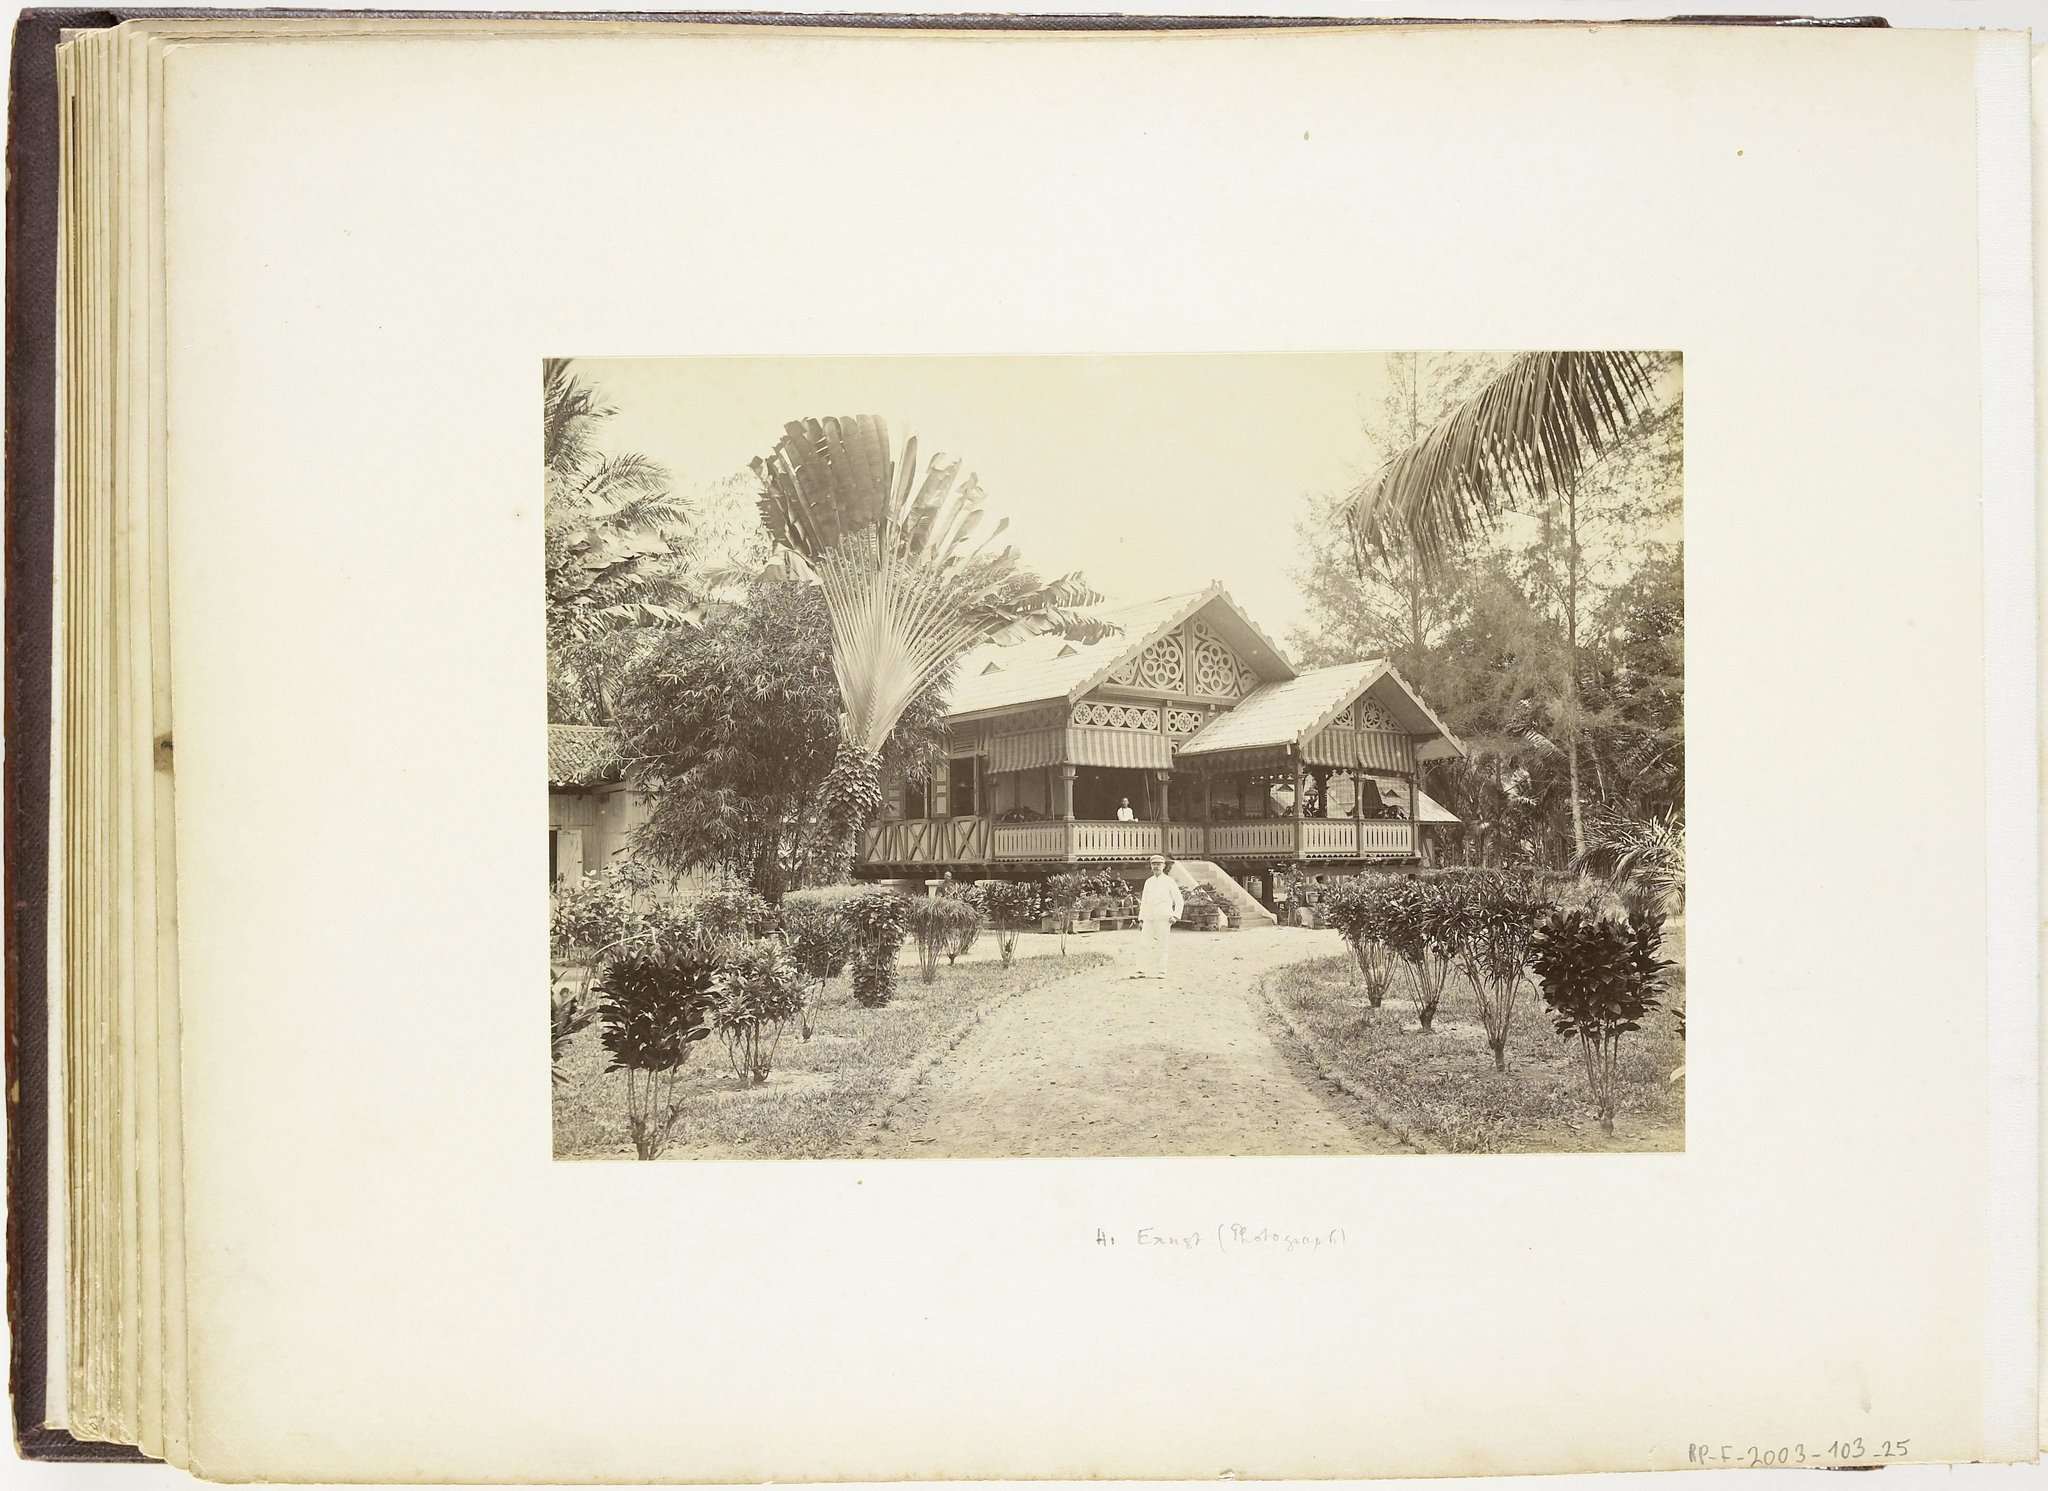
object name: photograph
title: Portret van de fotograaf H. Ernst voor zijn huis, Langkat Sumatra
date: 1890-1900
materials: cardboard, paper, photographic support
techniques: albumen print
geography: bindjai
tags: sumatra